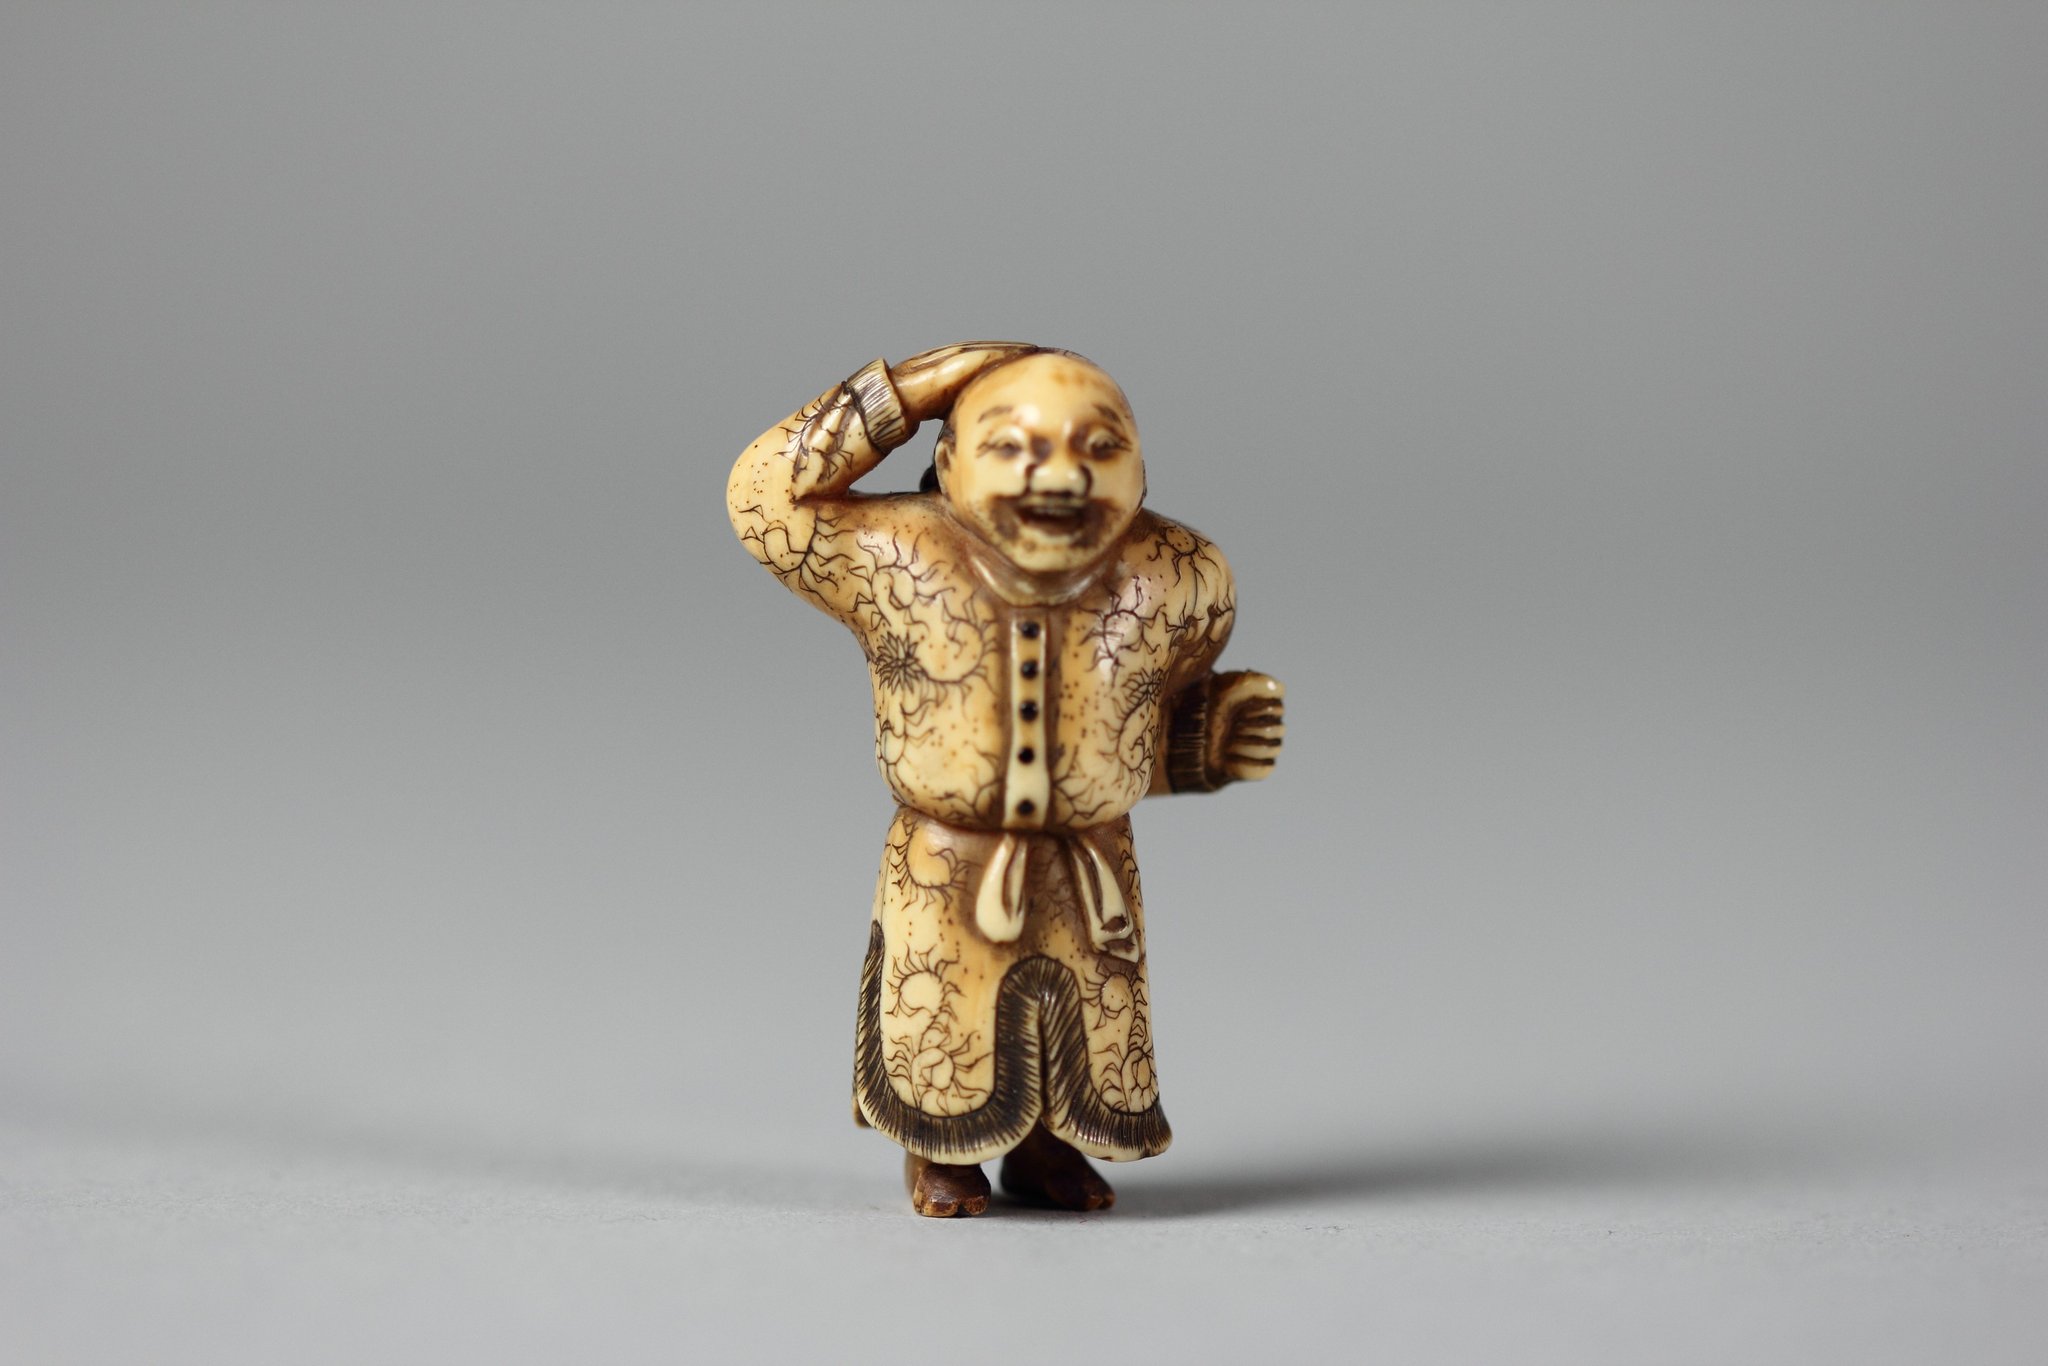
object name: netsuke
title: Netsuke of Man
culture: japanese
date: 1801-1900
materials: ivory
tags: men